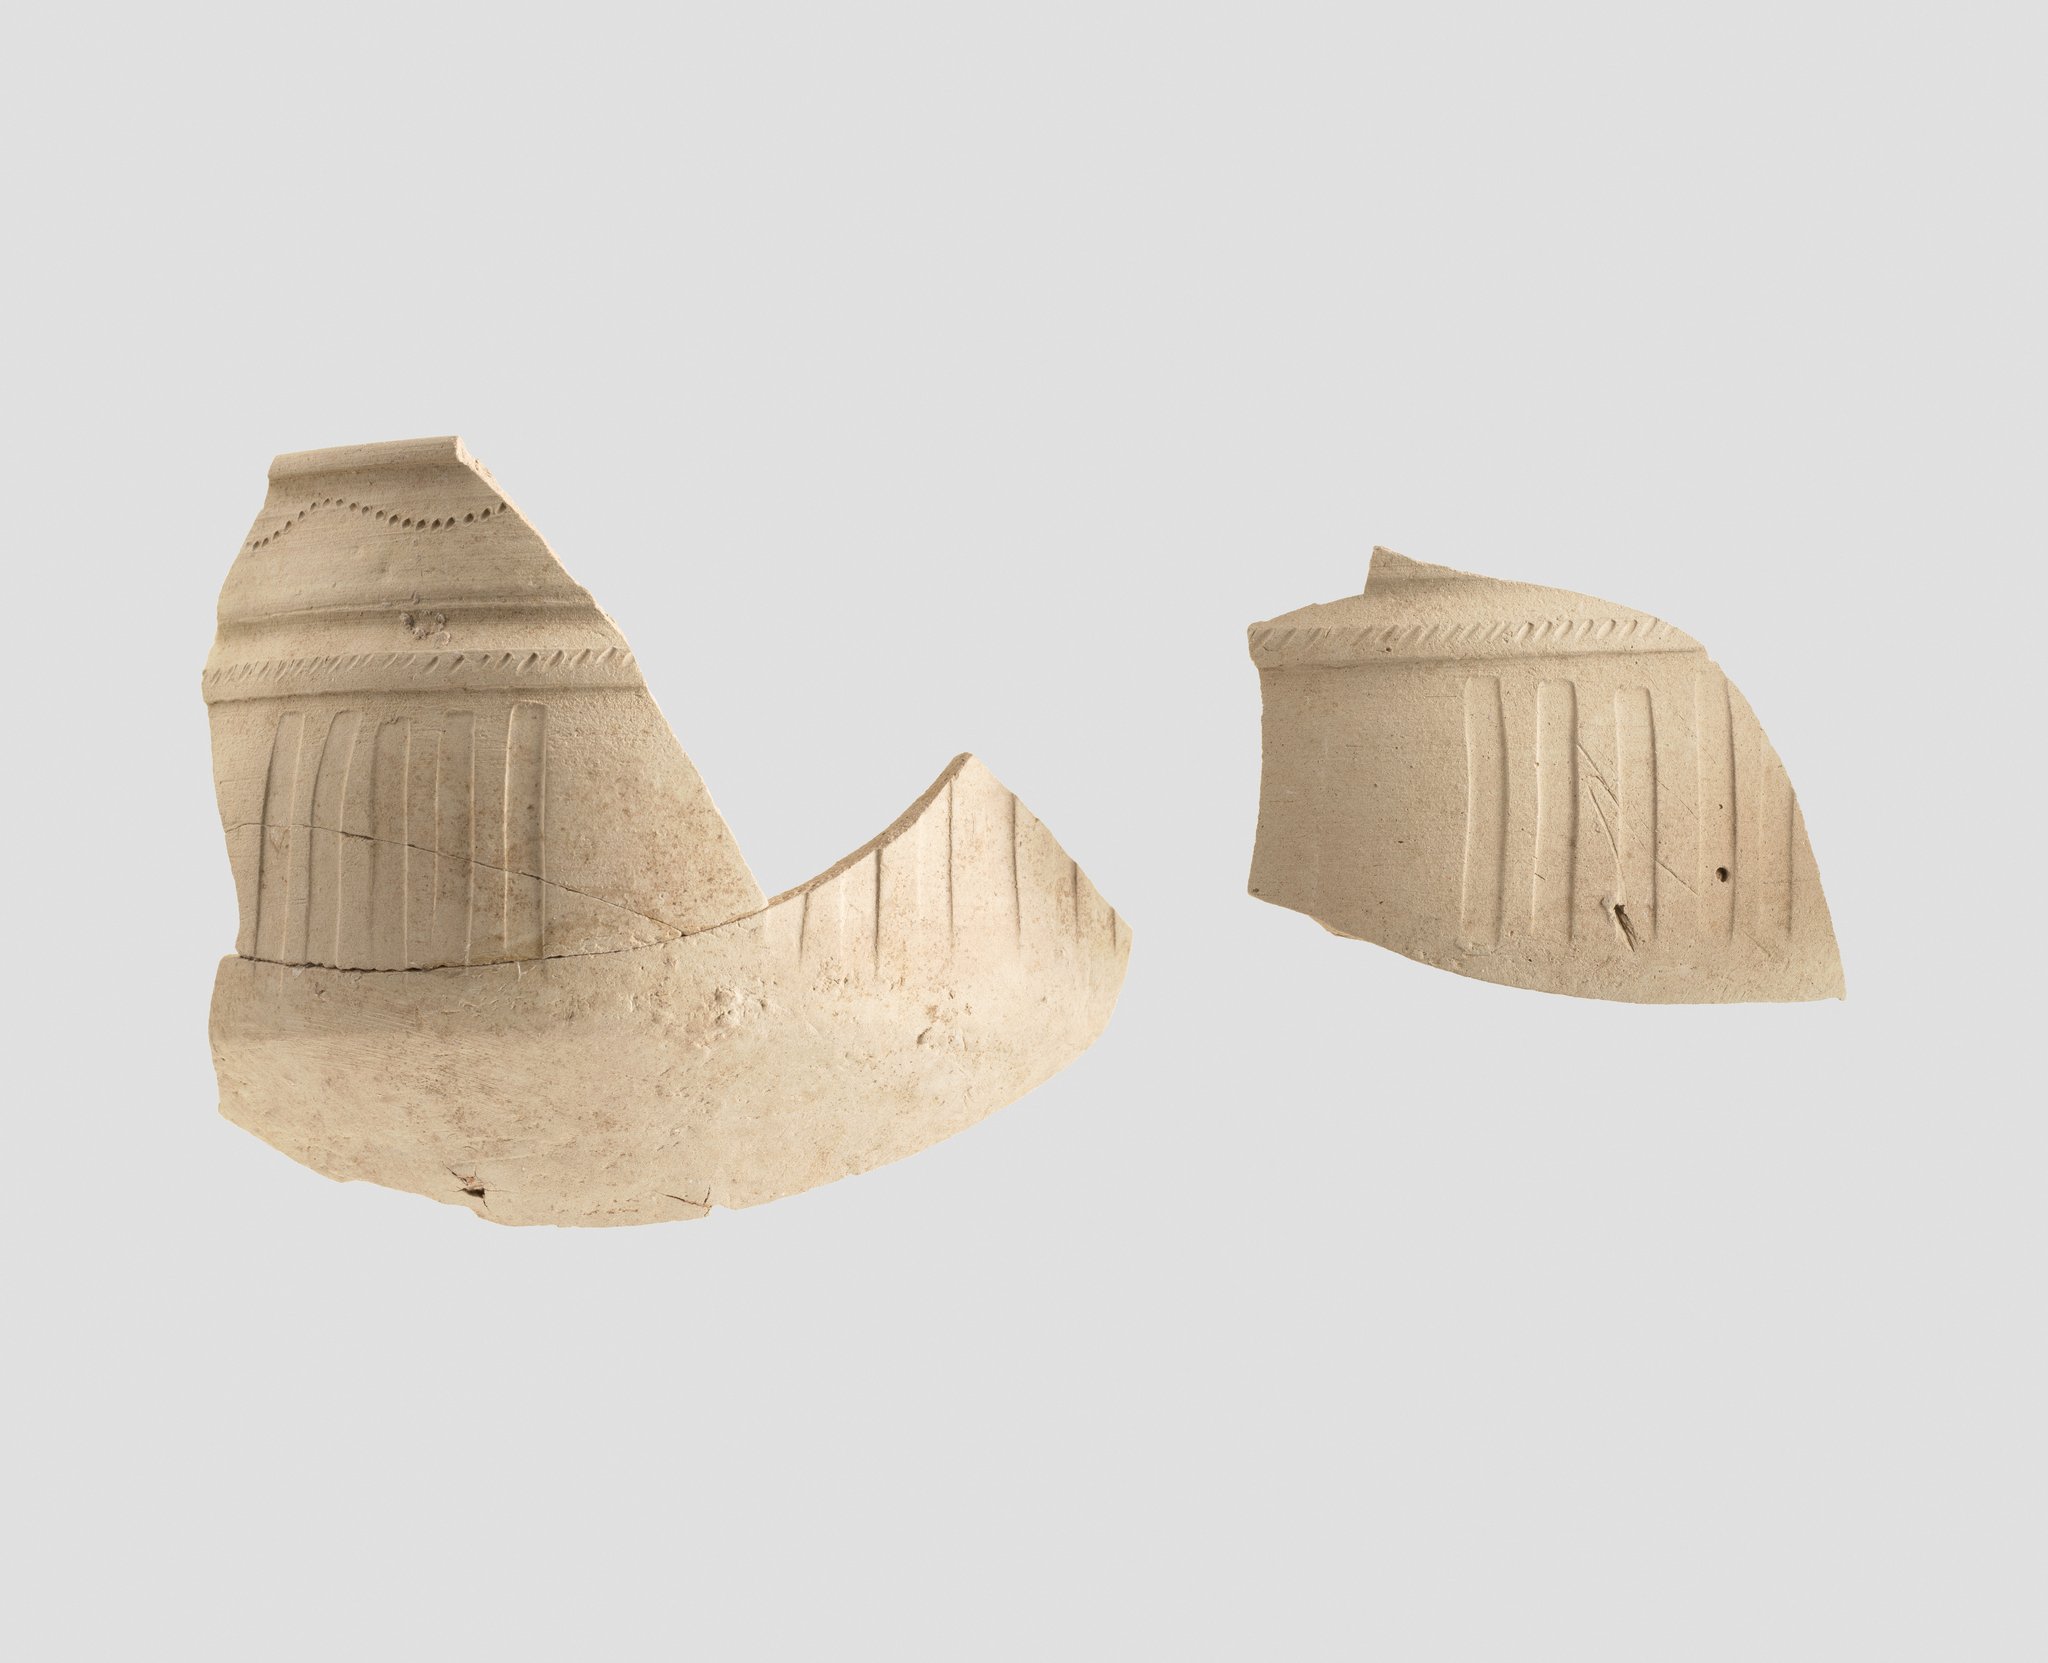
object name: sherd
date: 3100-2700 BCE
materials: ceramic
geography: syria